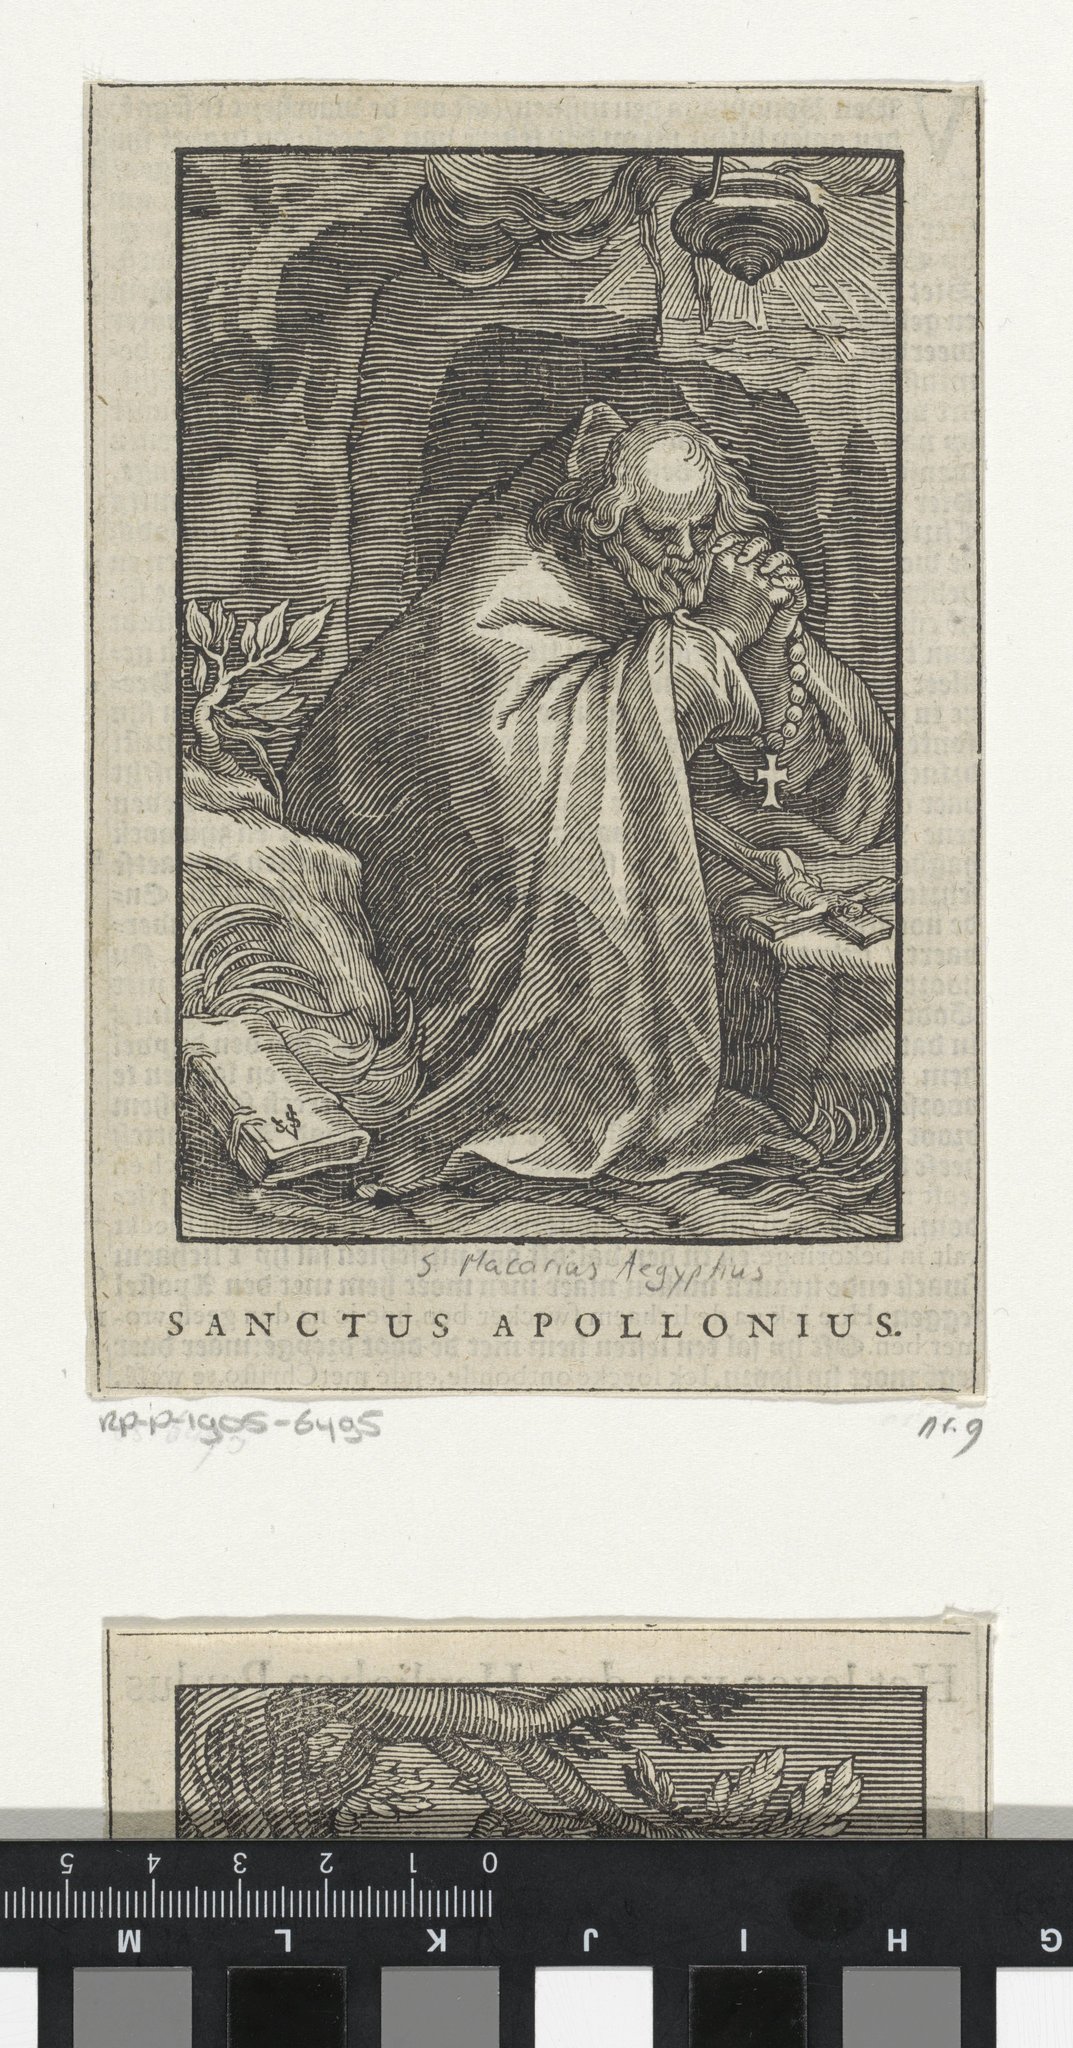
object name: print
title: Heilige Apollonius als kluizenaar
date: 1644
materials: paper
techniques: letterpress printing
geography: amsterdam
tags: male saints (with name), anchorite, hermit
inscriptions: collector's mark: Lugt 2228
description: Prent uit: Rosweyde, Heribert. 'tBosch der eremyten ende eremitinnen, van Aegypten ende Palestinen. Amsterdam: Pieter Jacobsz. Paets, 1644.